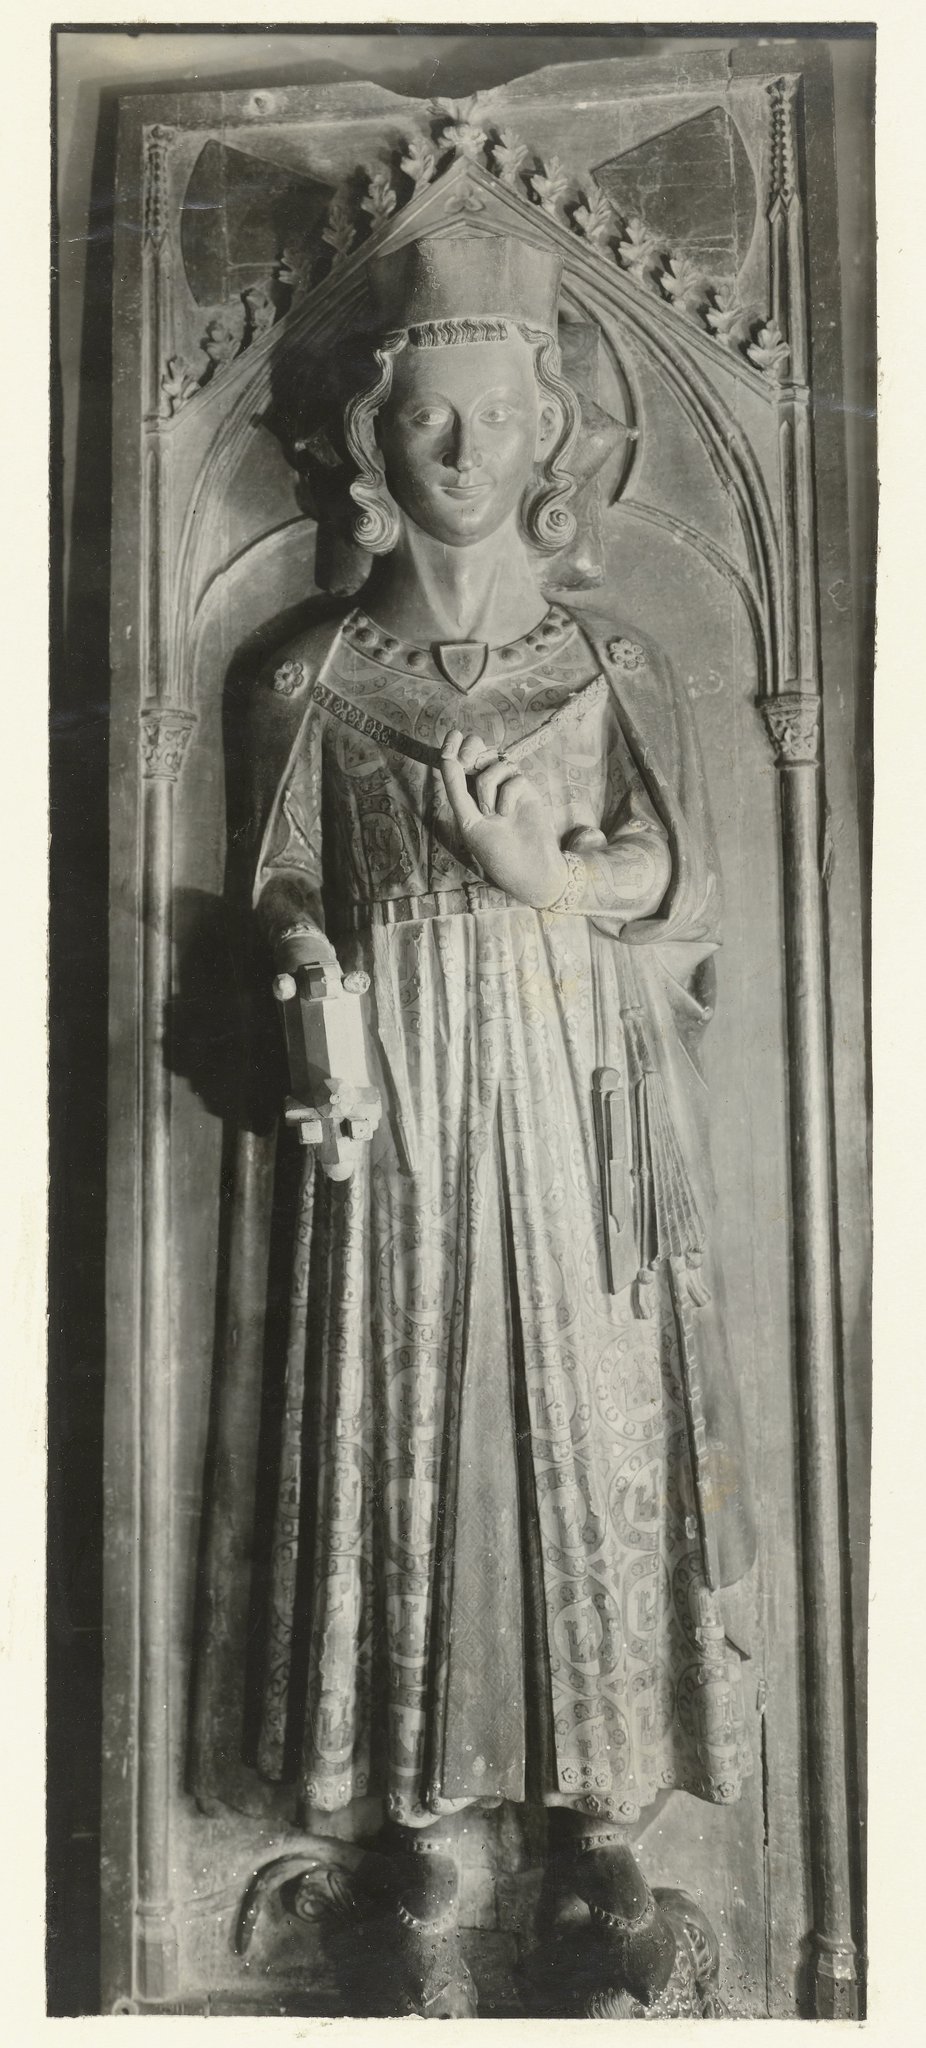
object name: photograph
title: Sculptuur van een heilige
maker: Anonymous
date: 1895-1920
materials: cardboard, paper, photographic support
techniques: collodion silver print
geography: amsterdam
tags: piece of sculpture, reproduction of a piece of sculpture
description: Het sculptuur is mogelijk onderdeel van een kerk